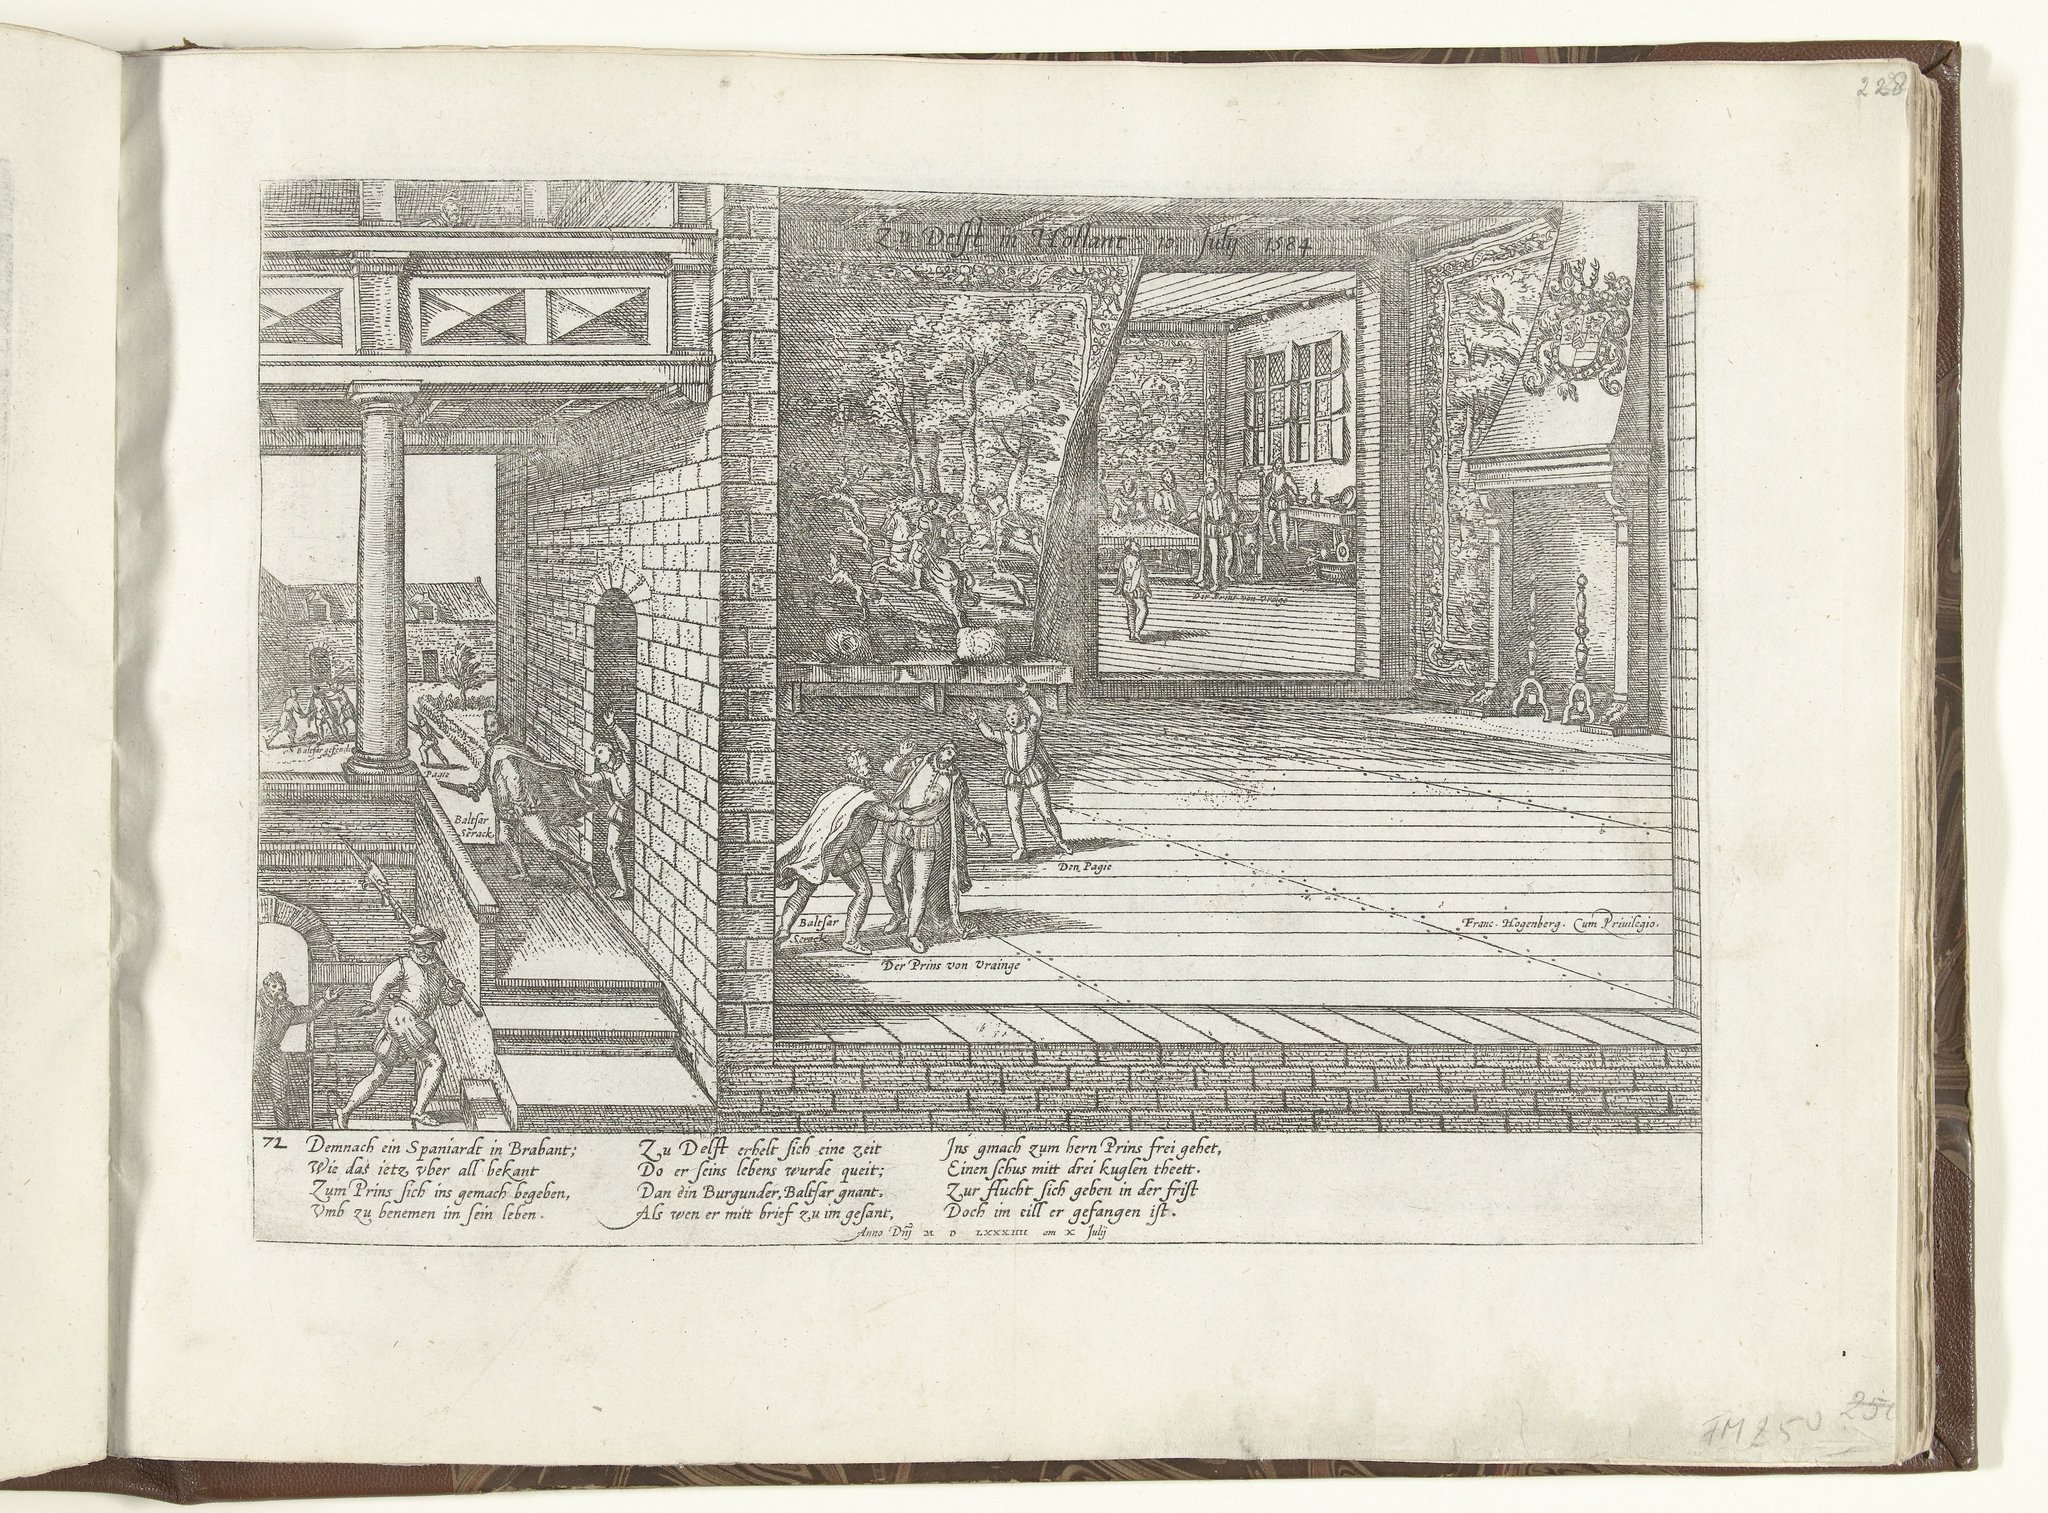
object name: print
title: Zu Delft in Hollant 10 Julij 1584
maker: frans hogenberg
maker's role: print maker, publisher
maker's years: 1538-1590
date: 1584-1586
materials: paper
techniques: etching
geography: cologne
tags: delft, william i (prince of orange), attempt, political murder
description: Willem van Oranje vermoord door Balthasar Gerards, 10 juli 1584. Gezicht op interieur Prinsenhof: achter ontvangt de prins Gerards in een kamer, op de voorgrond wordt de prins neergeschoten. Links probeert Gerard te ontsnappen en wordt hij gevangengenomen. Met onderschrift van 12 regels in het Duits. Genummerd: 72.